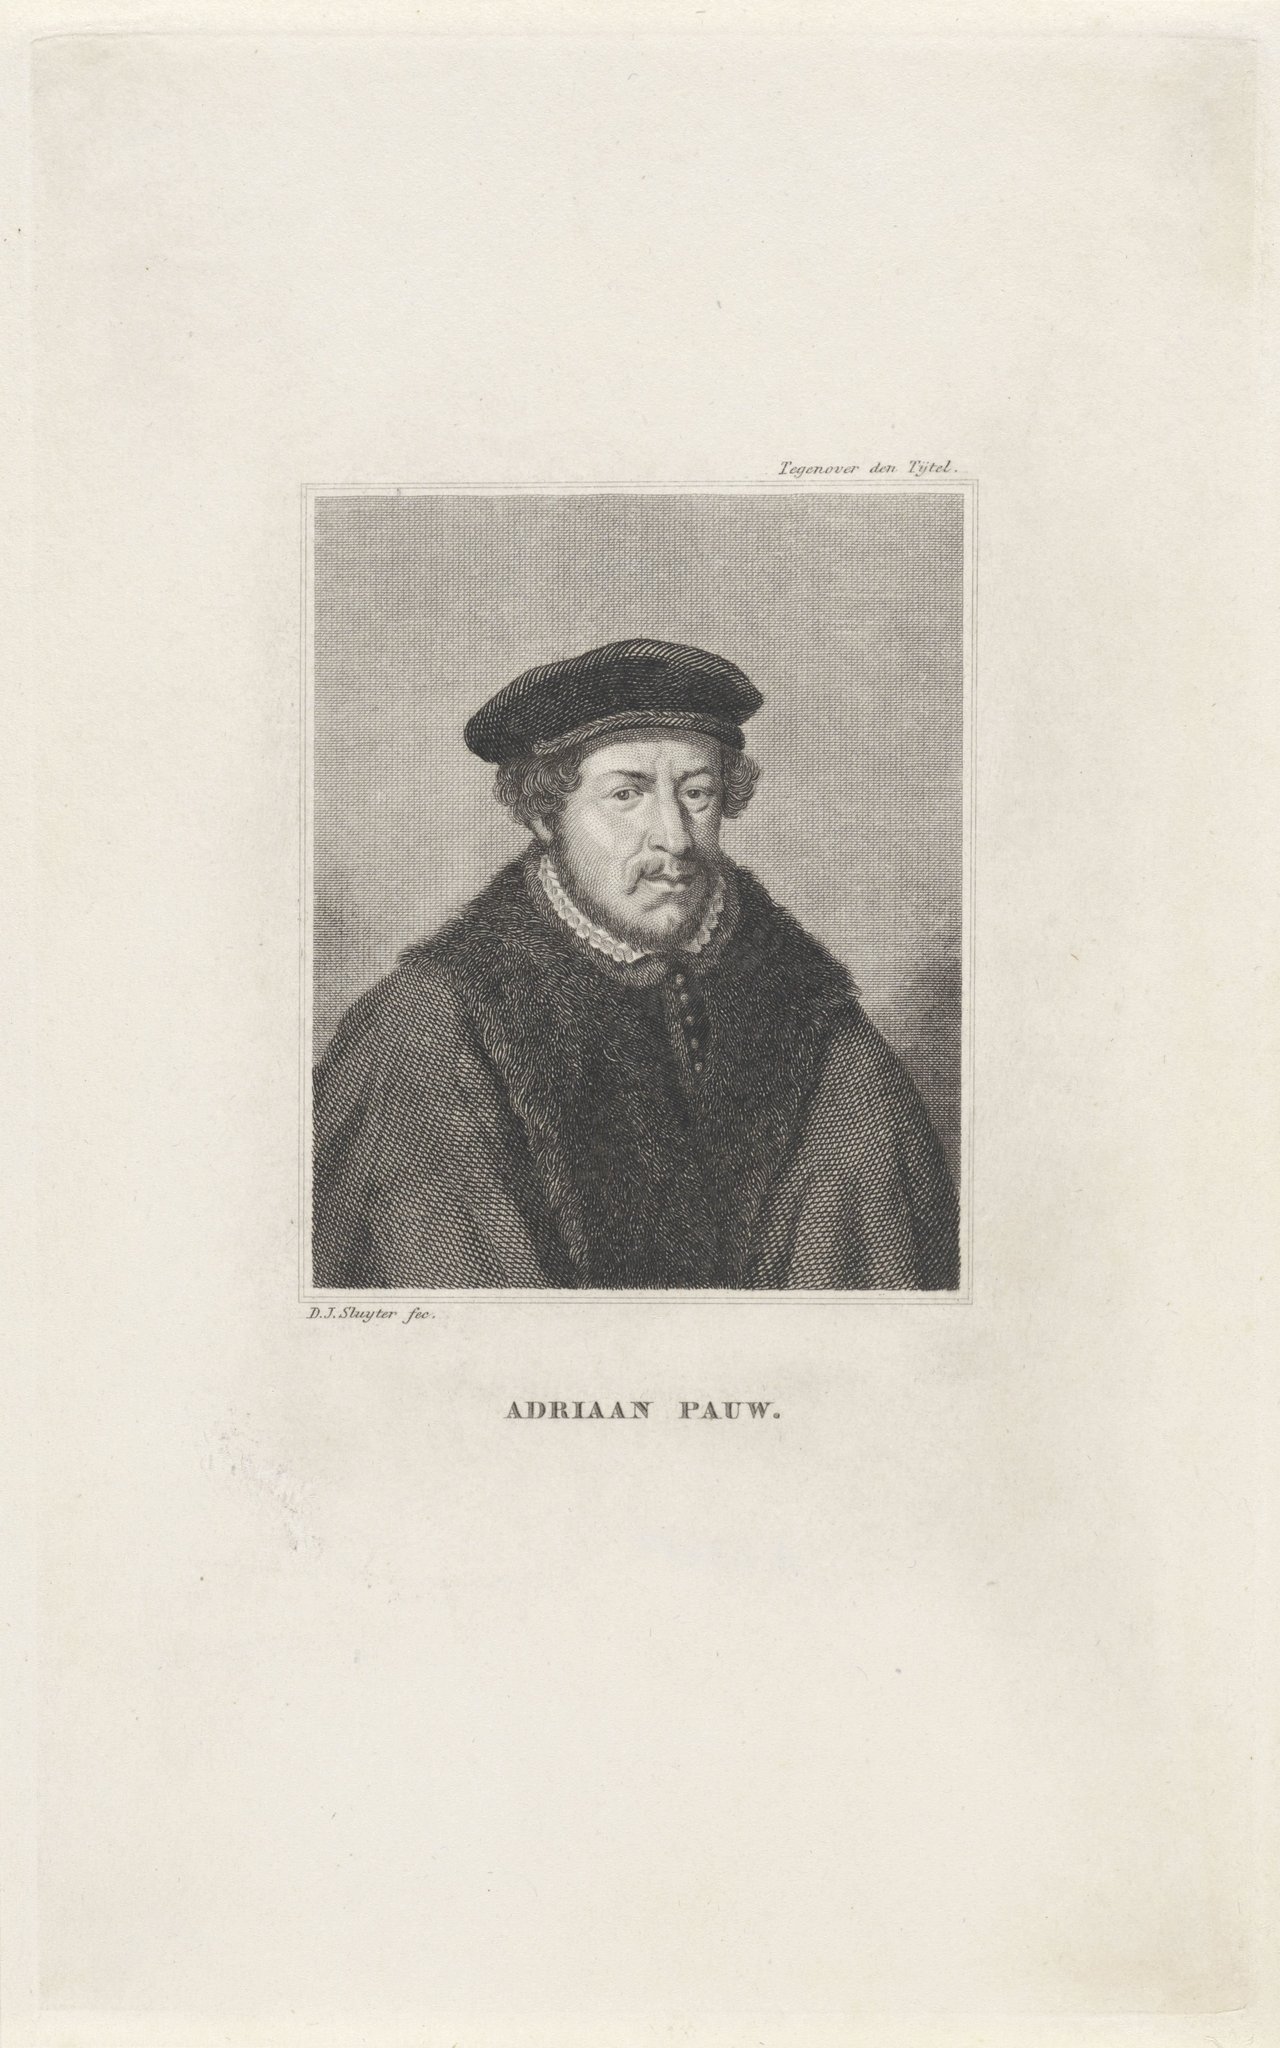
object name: book illustration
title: Portret van Adriaan Pauw (1516-1578)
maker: dirk jurriaan sluyter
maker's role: draughtsman, print maker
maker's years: 1811-1886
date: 1826-1886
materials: paper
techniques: etching, engraving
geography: amsterdam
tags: head-gear: cap (+ men's clothes)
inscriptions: collector's mark: Lugt 2228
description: Portret van de Amsterdamse schepen Adriaan Pauw (1516-1578). Onder het portret zijn naam. Erboven de vermelding "tegenover den tijtel".